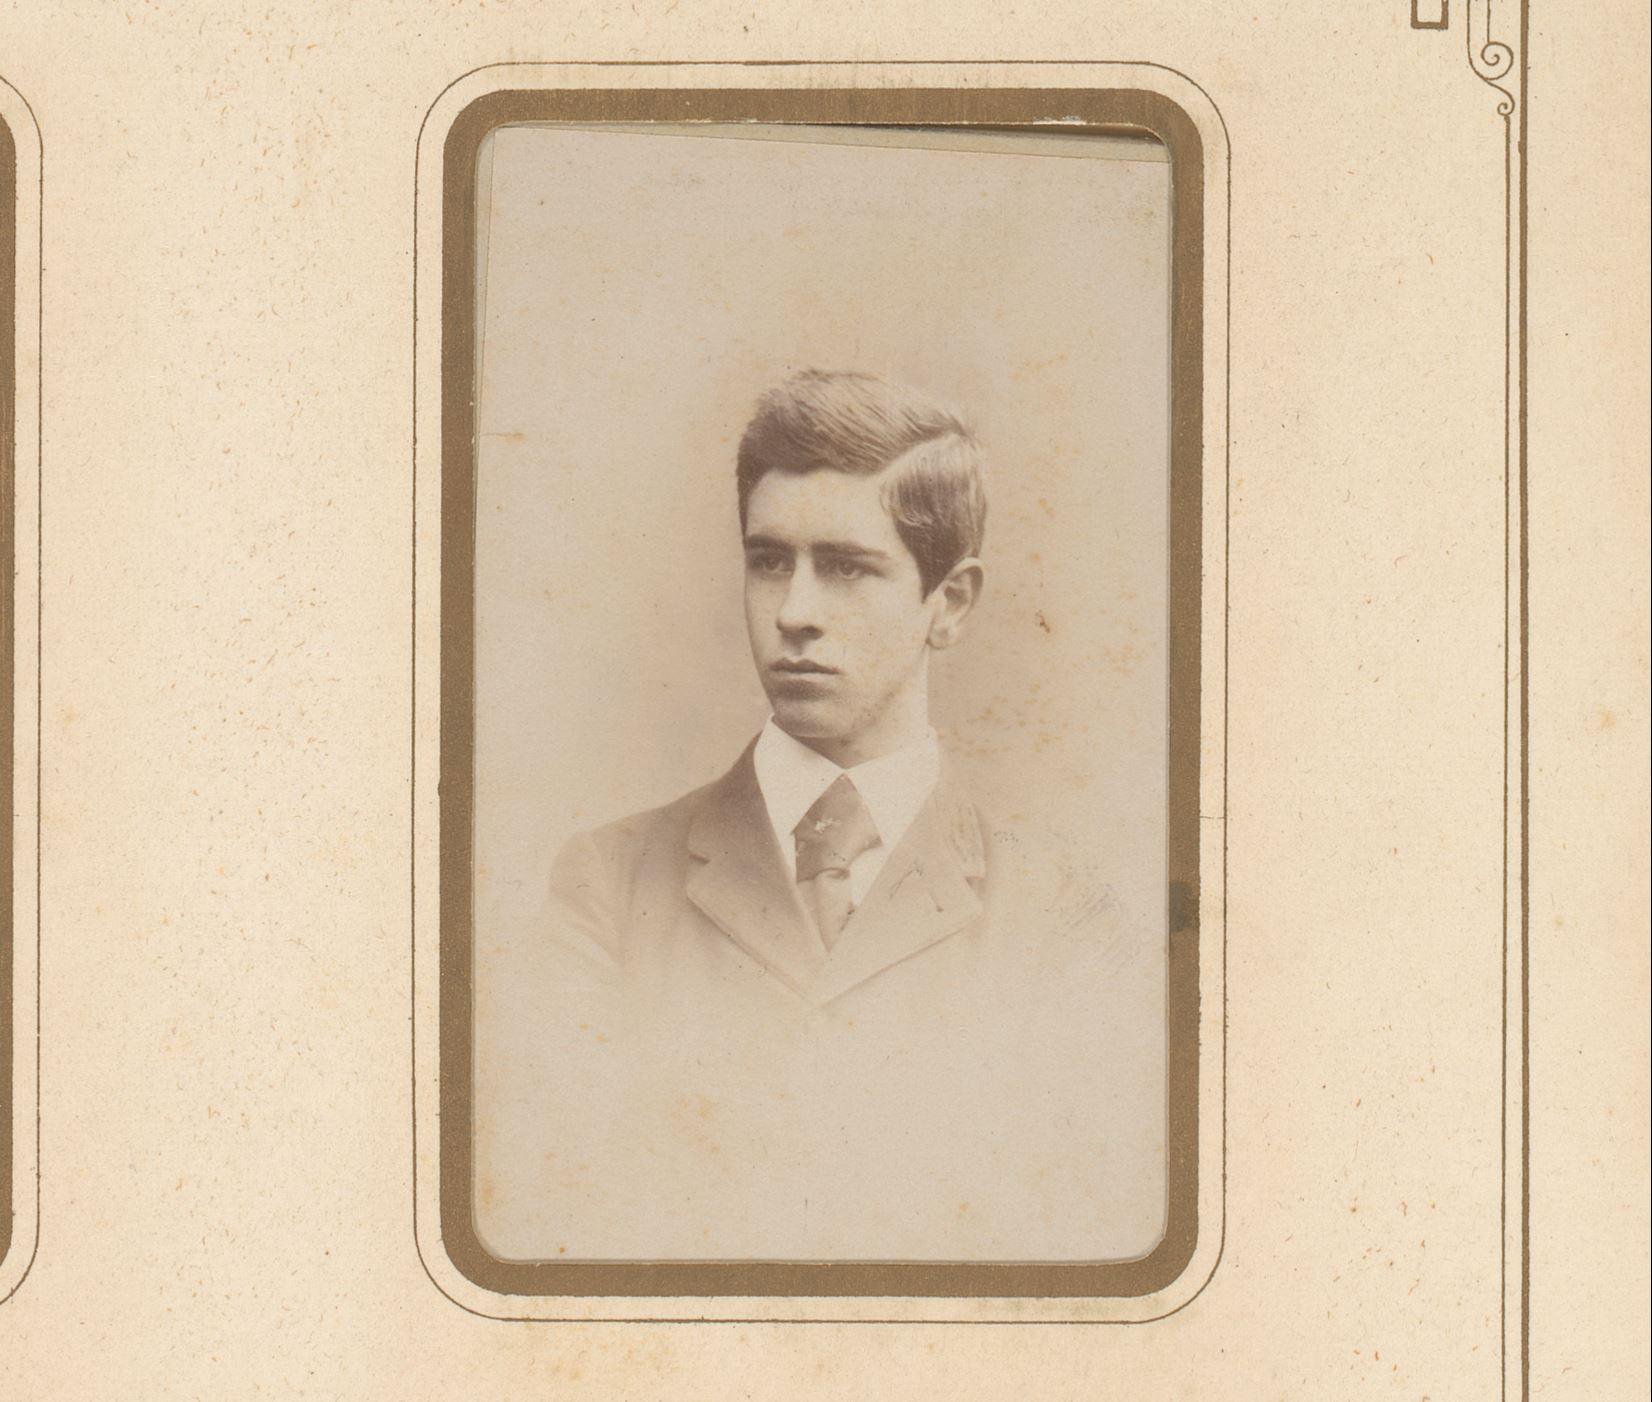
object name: album leaf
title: Portret van een jongeman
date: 1894-1906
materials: cardboard, photographic support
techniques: albumen print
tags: historical persons, youth, adolescent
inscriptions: inscription: ‘(...)/ Theunisse & Labots/ voorheen Ed. Radermacher/ Rotterdam/ Kruiskade 20/ hoek Kerklaan.’